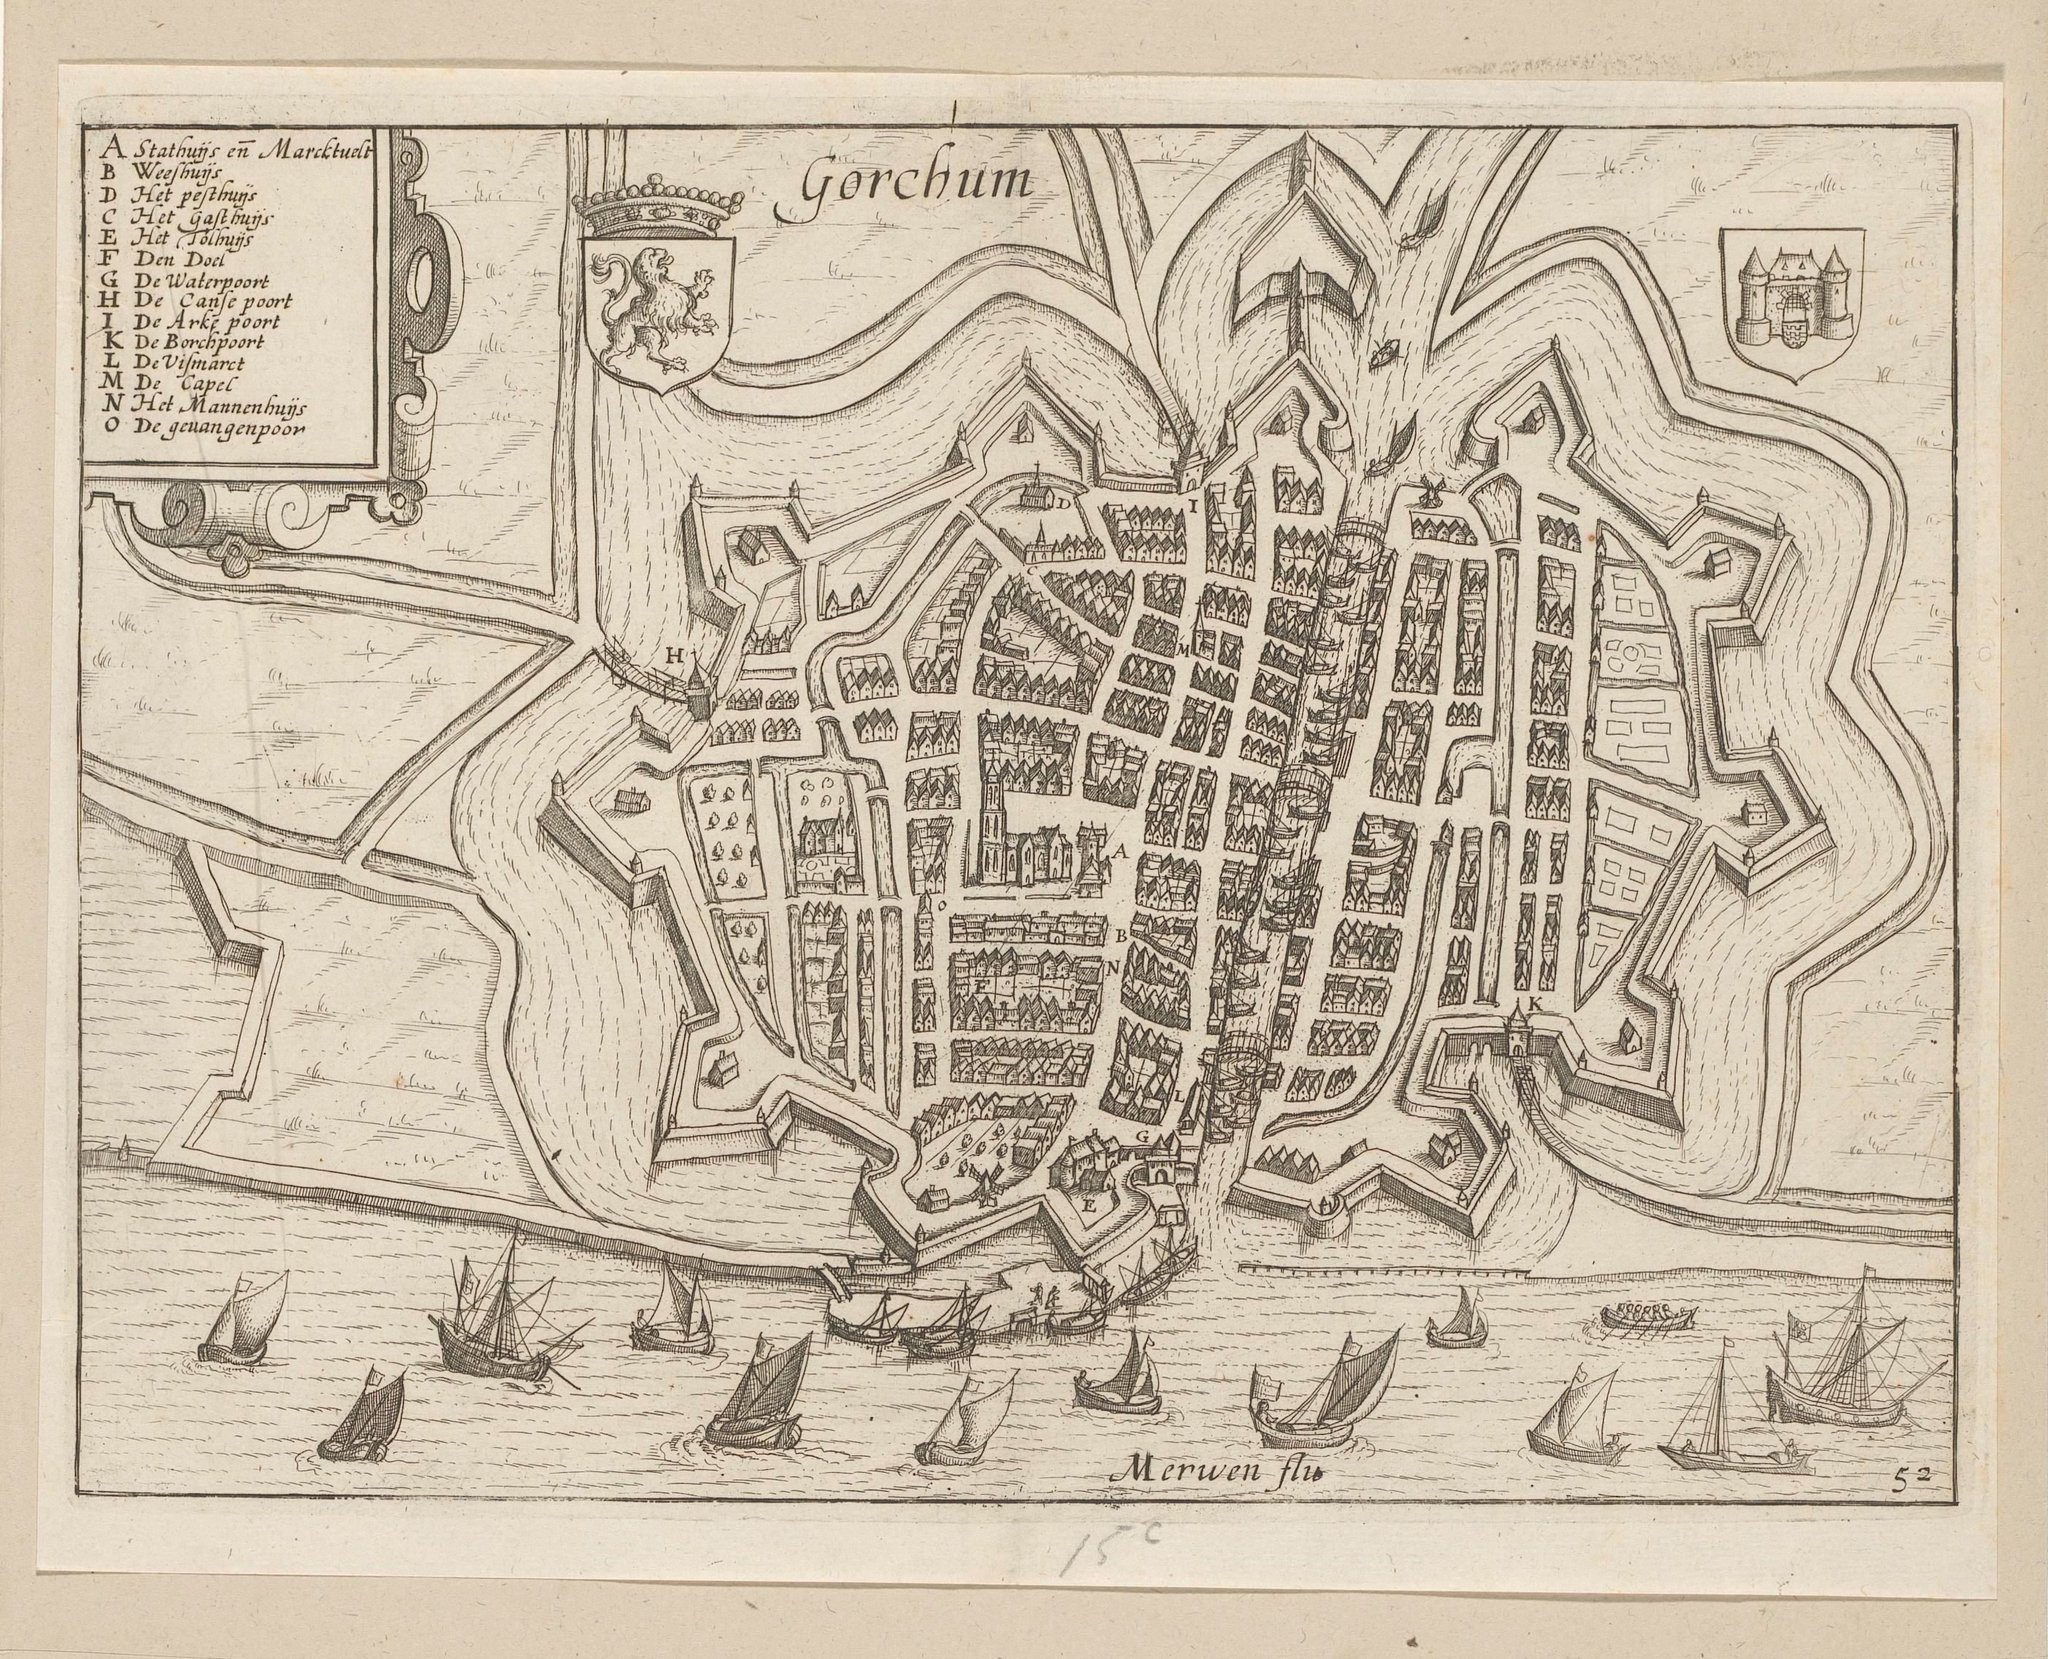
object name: area plan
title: Gorchum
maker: Anonymous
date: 1612-1648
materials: paper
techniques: etching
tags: coat of arms (as symbol of the state, etc.) (+ city; municipal), maps of cities, coat of arms (as symbol of the state, etc.) (+ province; provincial)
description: Deze staat van prent voor het eerst ook gebruikt in: Guicciardini, Lodovico. Beschryvinghe van alle de Neder-landen, anderssins ghenoemt Neder-Duytslandt (…). Amsterdam: Willem Janszoon Blaeu, 1612. Hierna is deze prent tot 1648 nog gebruikt in latere uitgaven van deze publicatie, uitgegeven door Blaeu en daarna door Janssonius. Uit welke uitgave het huidige exemplaar precies komt is niet na te gaan.